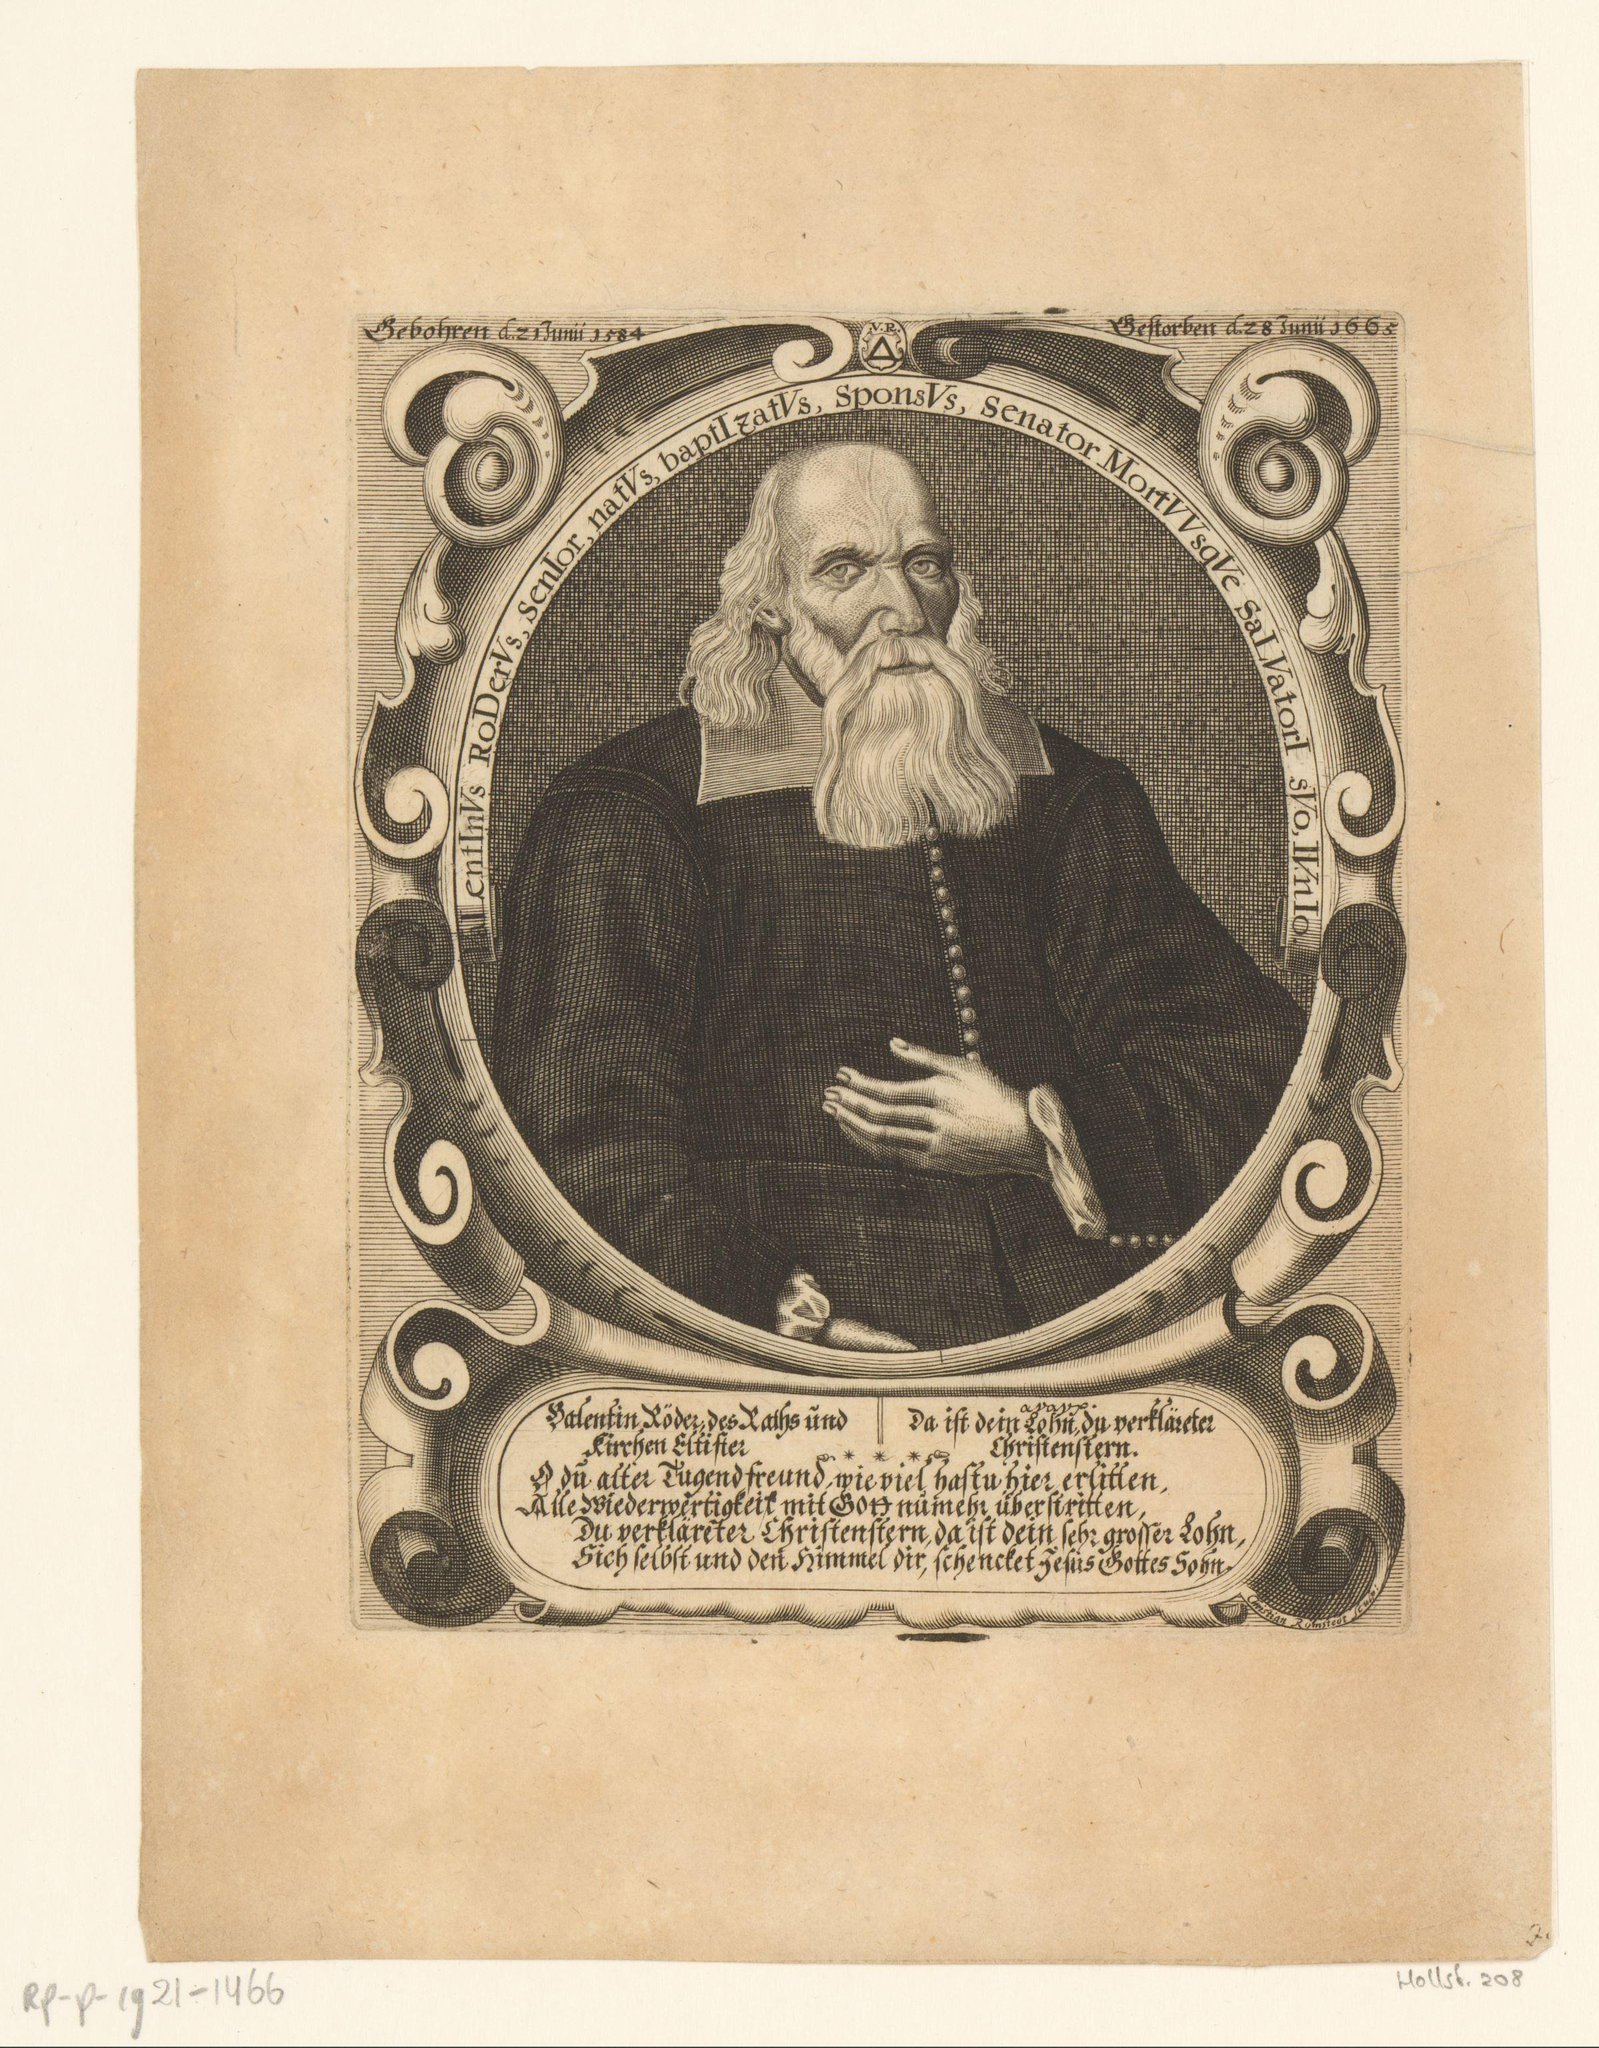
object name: print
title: Portret van Valentin Röder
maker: christian romstet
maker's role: print maker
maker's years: 1640-1721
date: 1665-1721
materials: paper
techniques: engraving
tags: historical persons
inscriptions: collector's mark: Lugt 2228